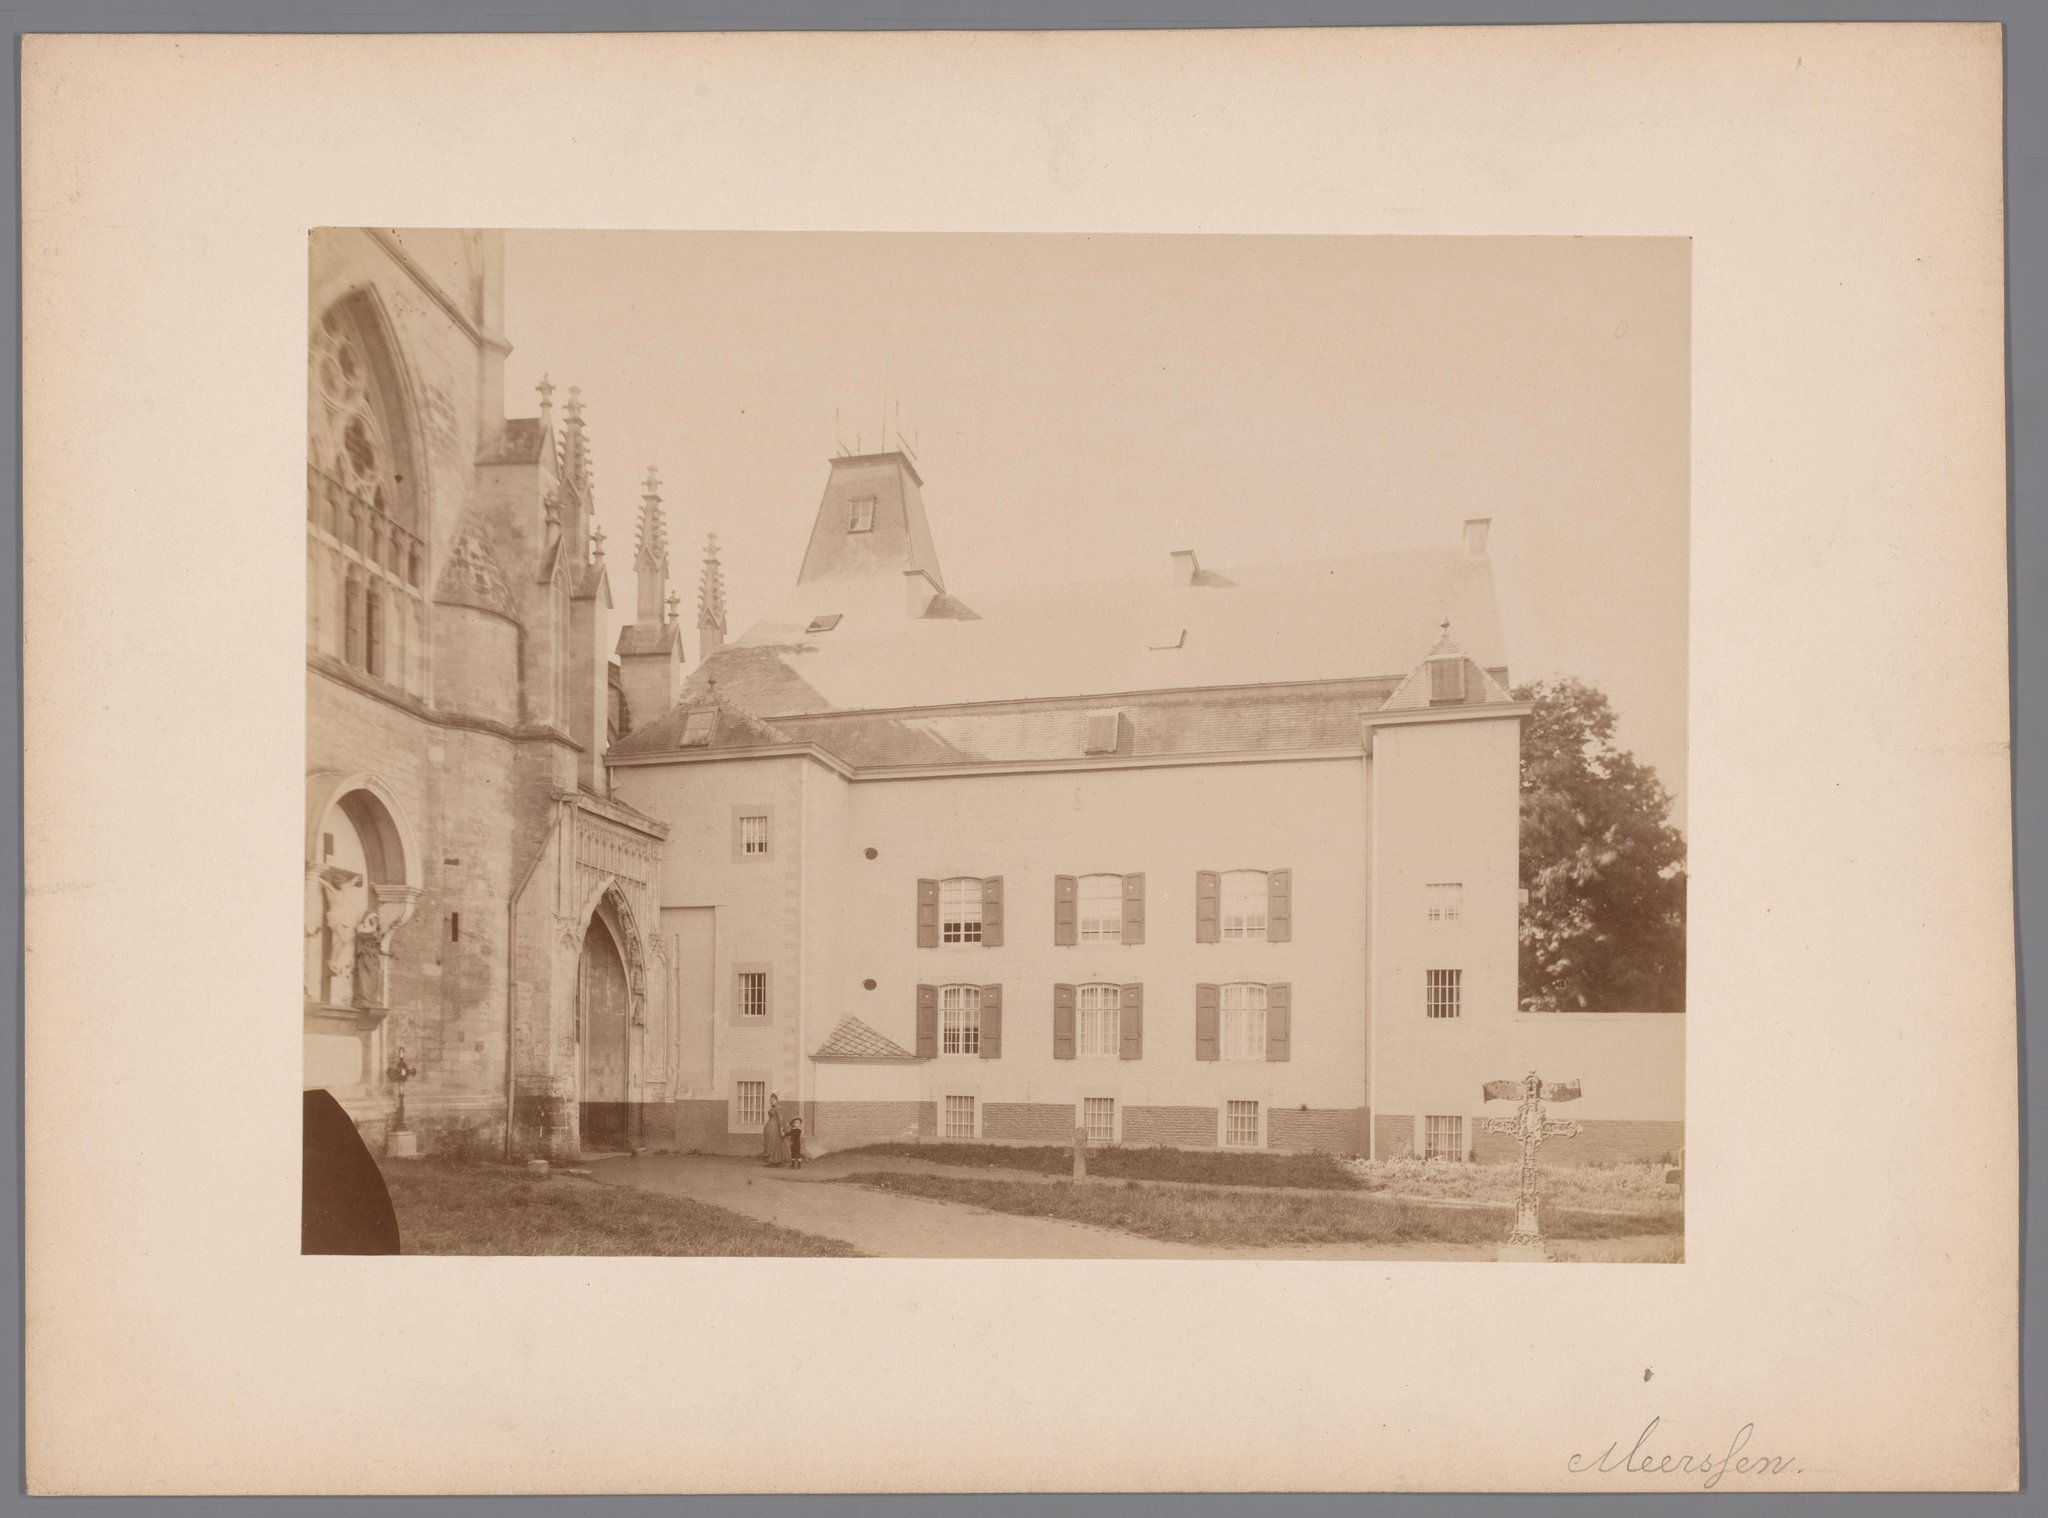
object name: photograph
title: Noordzijde van de Sint-Bartholomeusbasiliek te Meerssen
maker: anoniem (monumentenzorg)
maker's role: fotograaf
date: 1890-1920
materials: cardboard, photographic support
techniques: albumen print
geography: meerssen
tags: church (exterior)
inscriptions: annotation: ‘Meerssen/ Noordzijde kerk en [...]’, annotation: ‘Meerssen’